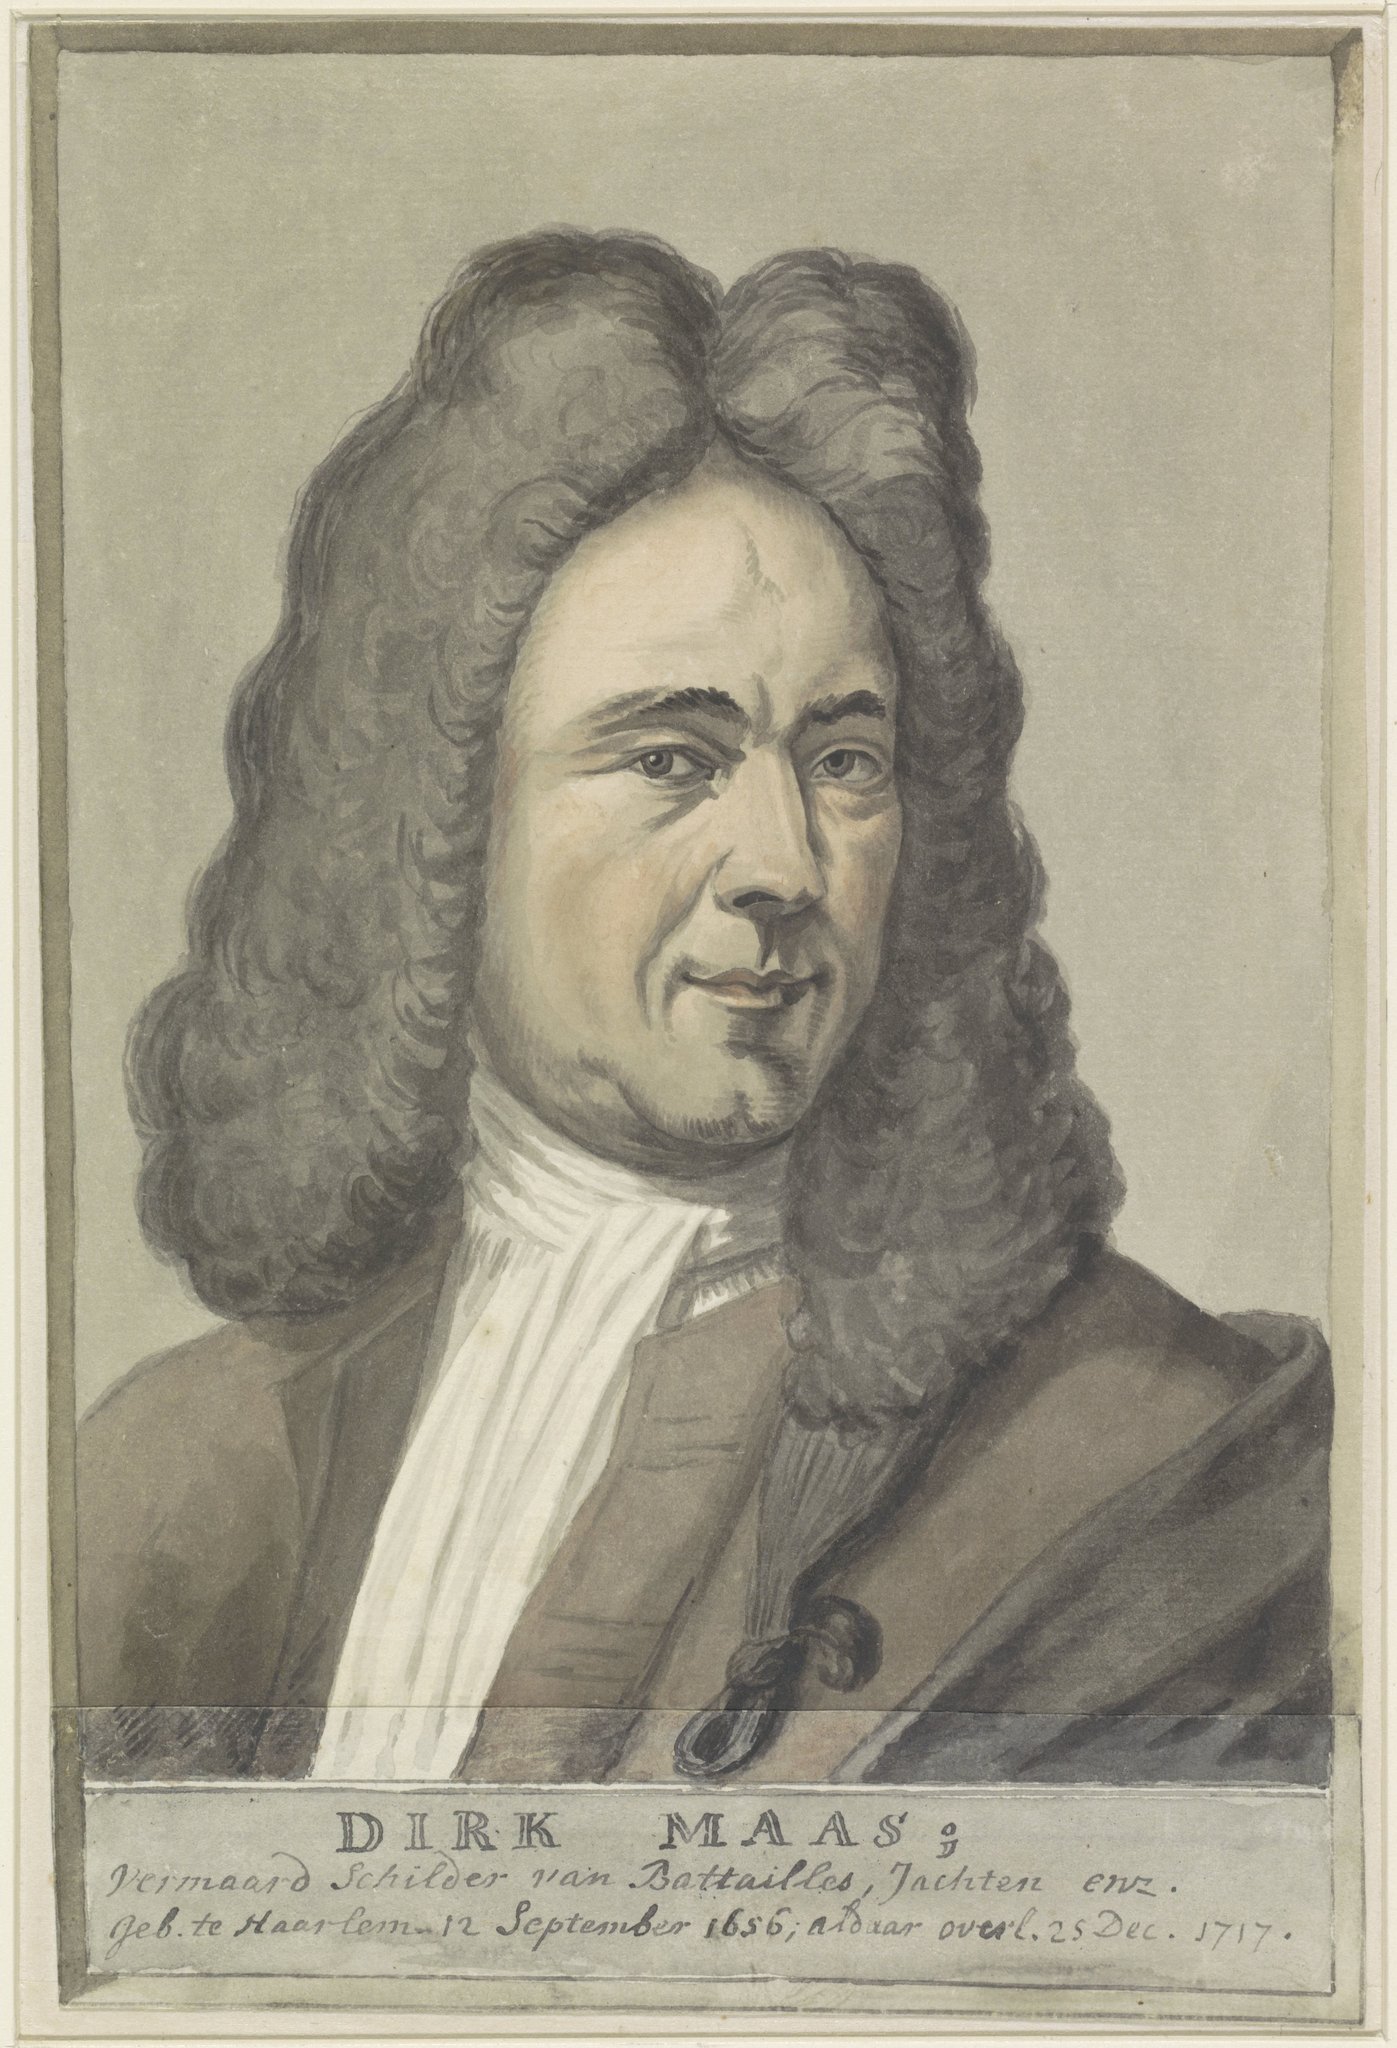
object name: drawing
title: Portret van Dirk Maes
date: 1741-1795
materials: paper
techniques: brush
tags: haarlem, print maker, draughtsman, dirk maas, historical persons, portrait, self-portrait of painter, portrait, self-portrait of artist